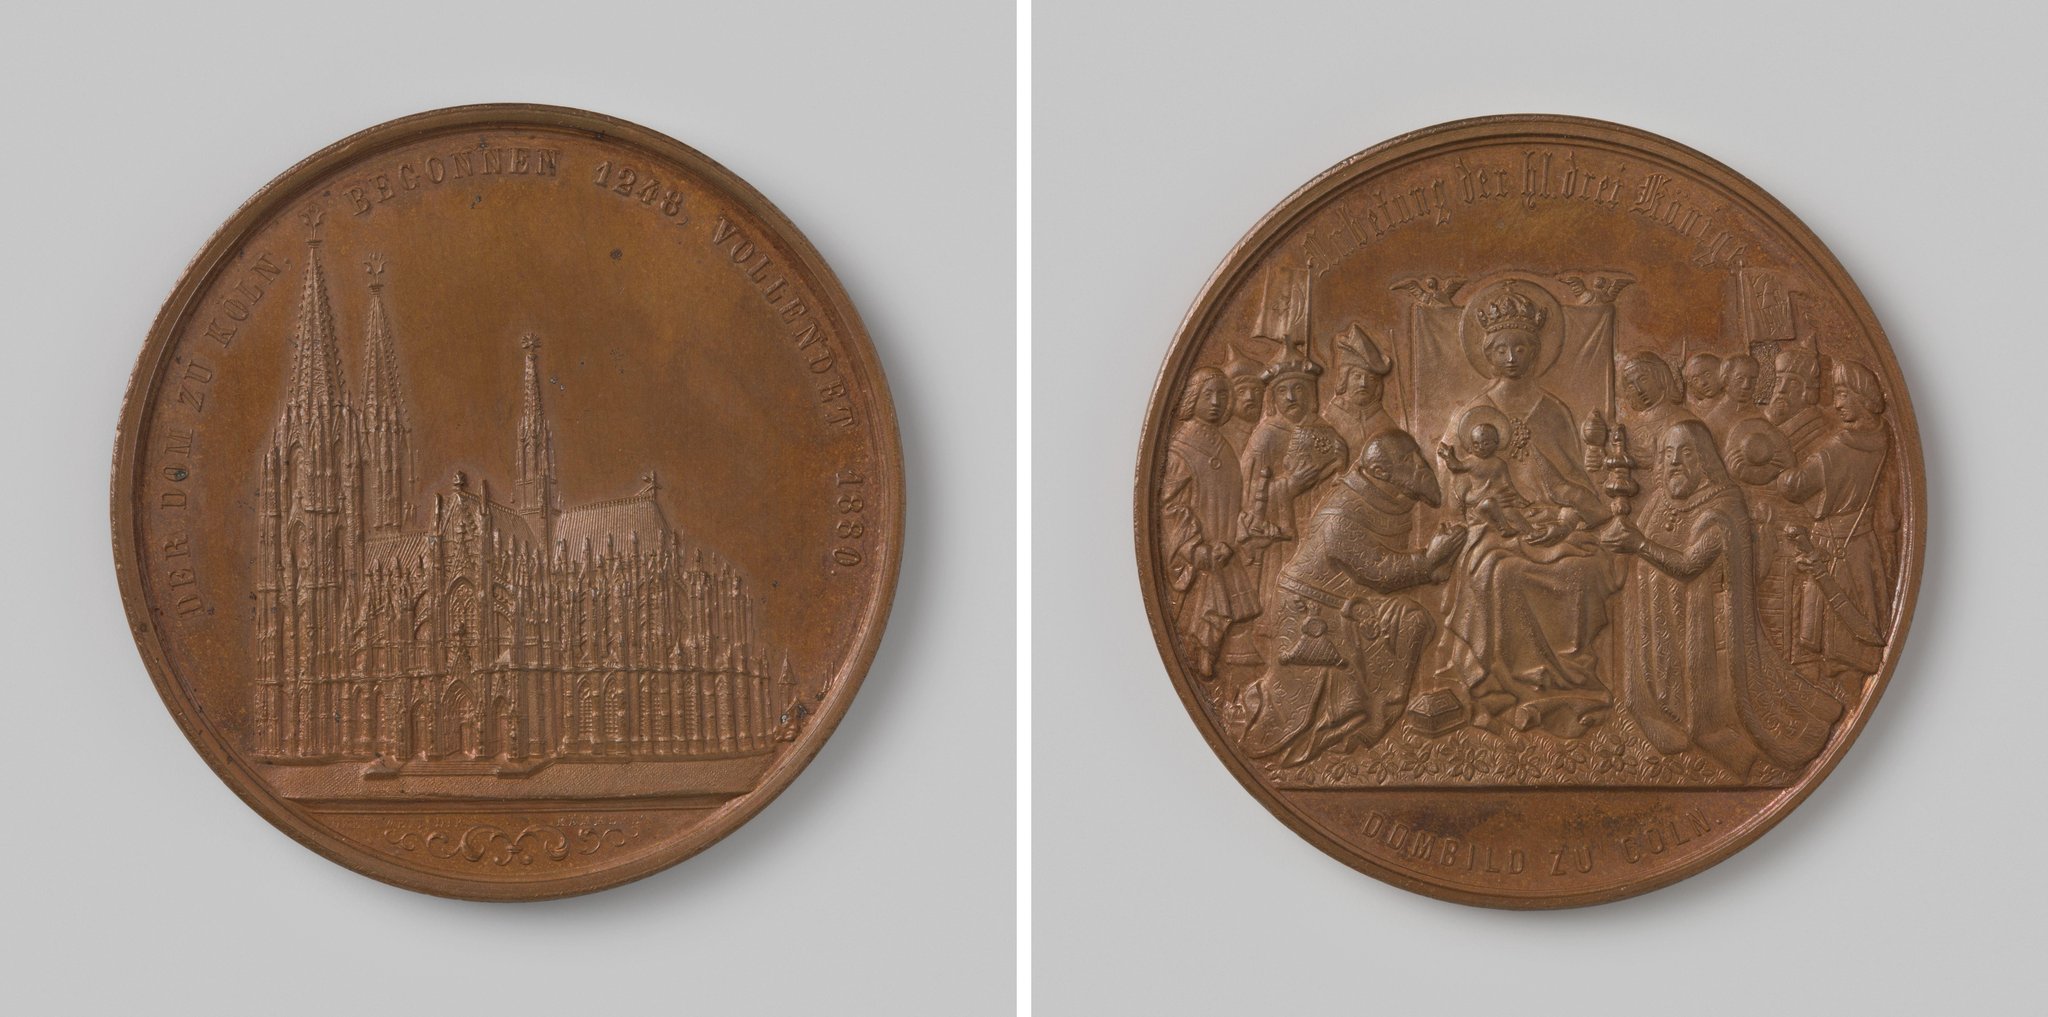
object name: history medal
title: Voltooiing van de Dom te Keulen 1880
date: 1880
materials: bronze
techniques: striking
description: Bronzen penning, op de voorzijde de Domkerk met omschrift en versierde afsnedetekst, op de keerzijde de Aanbidding der Koningen met omschrift en afsnedetekst.